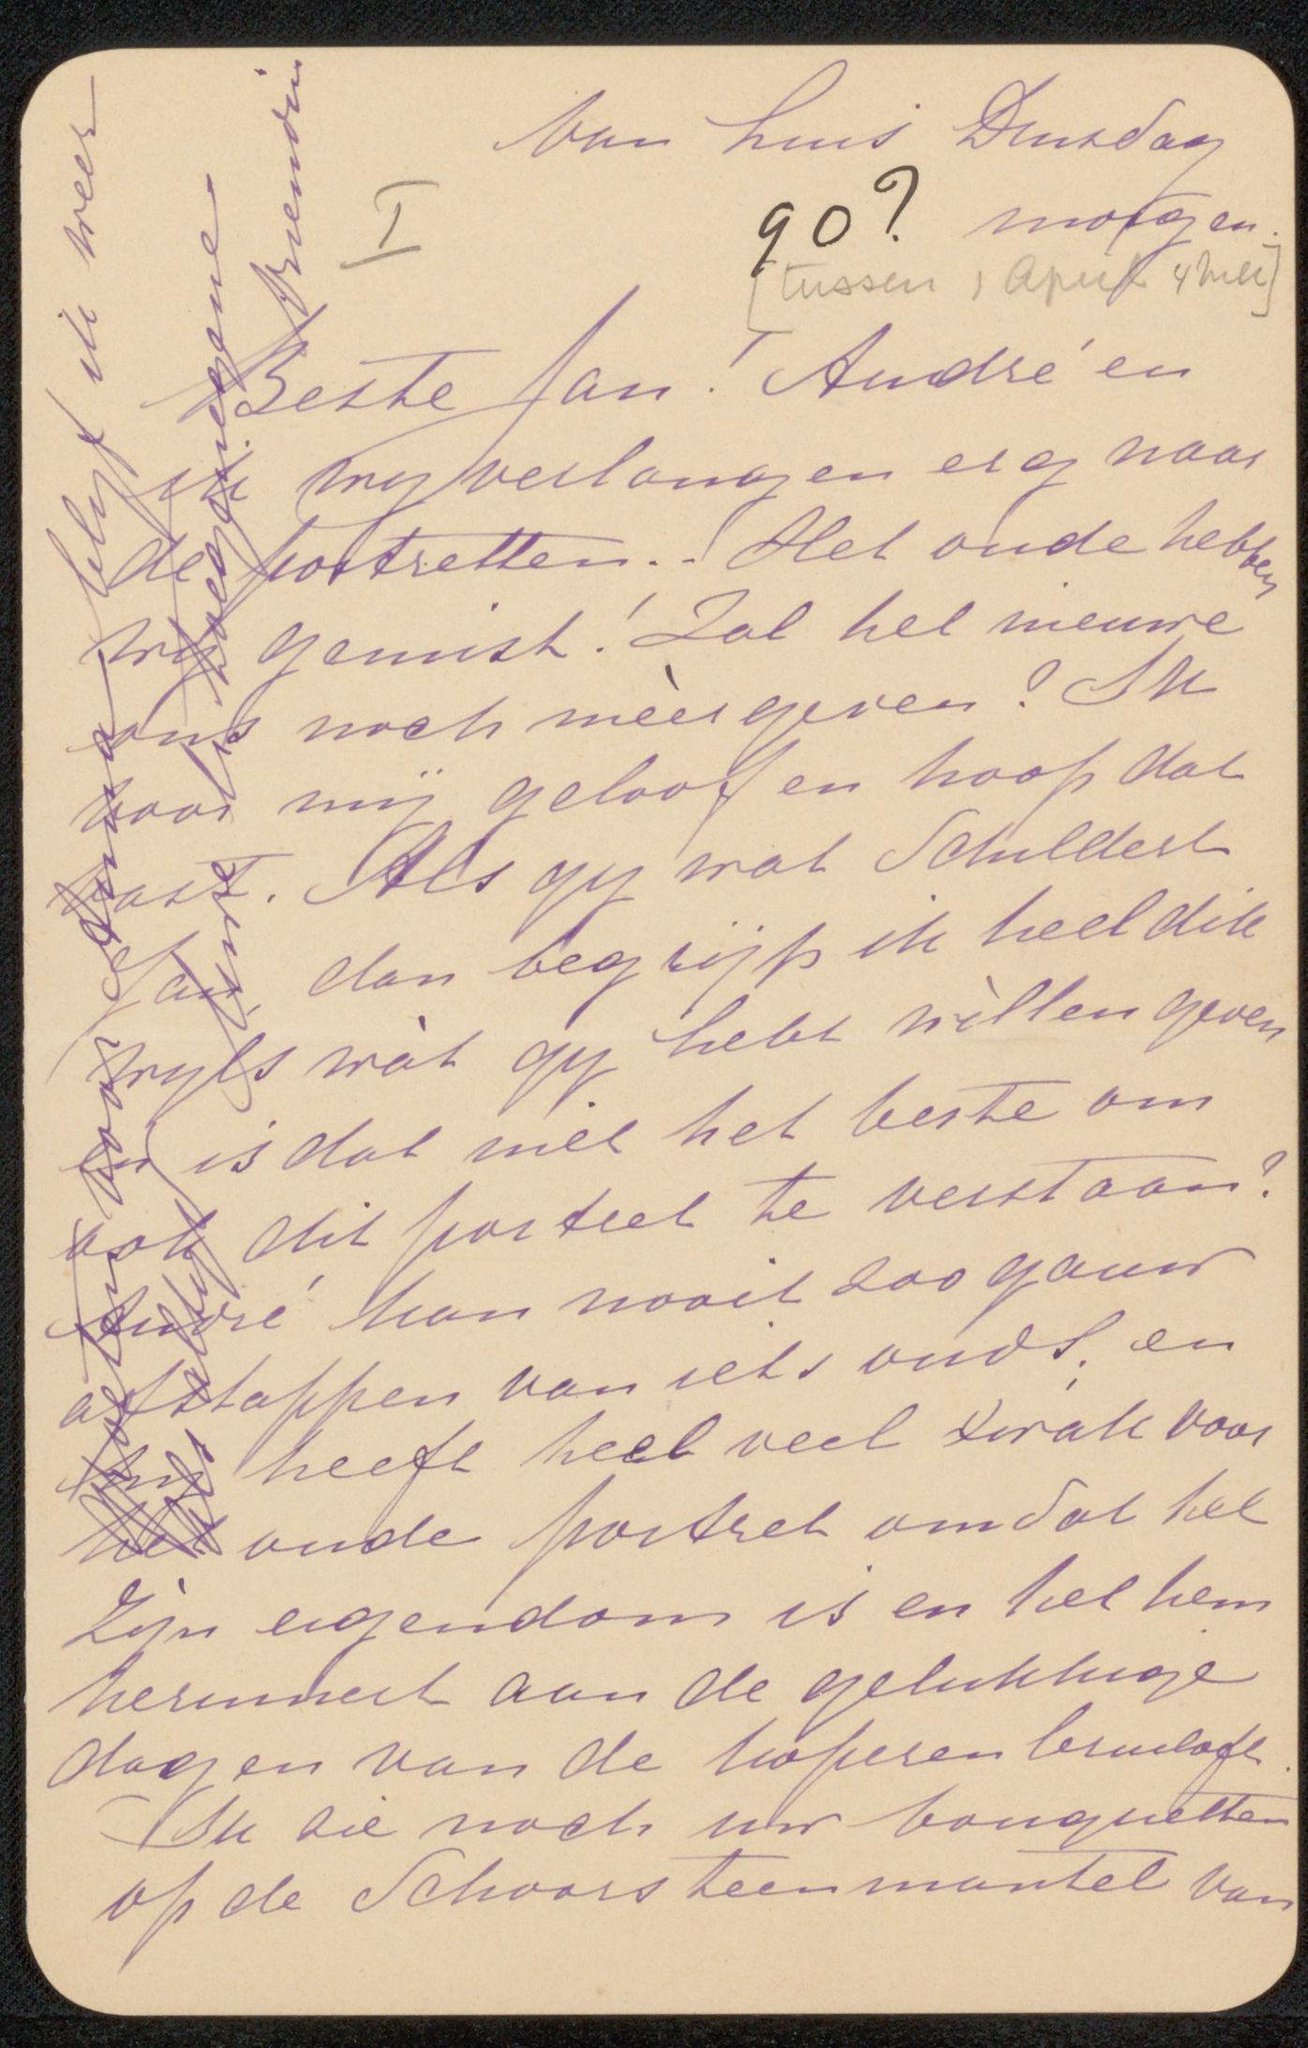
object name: letter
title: Brief aan Jan Veth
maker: jacoba cornelia jolles-singels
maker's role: schrijver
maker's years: 1847-1901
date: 1890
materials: ink, paper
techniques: pen, writing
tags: thérèse schwartze, the hague, painter, print maker, draughtsman, johannes bosboom, dordrecht, designer, jan veth, newspaper, utrecht, etha fles, leiden, amsterdam, physicist, andré jolles, literature ~ arts, historical persons (portraits and scenes from the life)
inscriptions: collector's mark: ‘RPK’